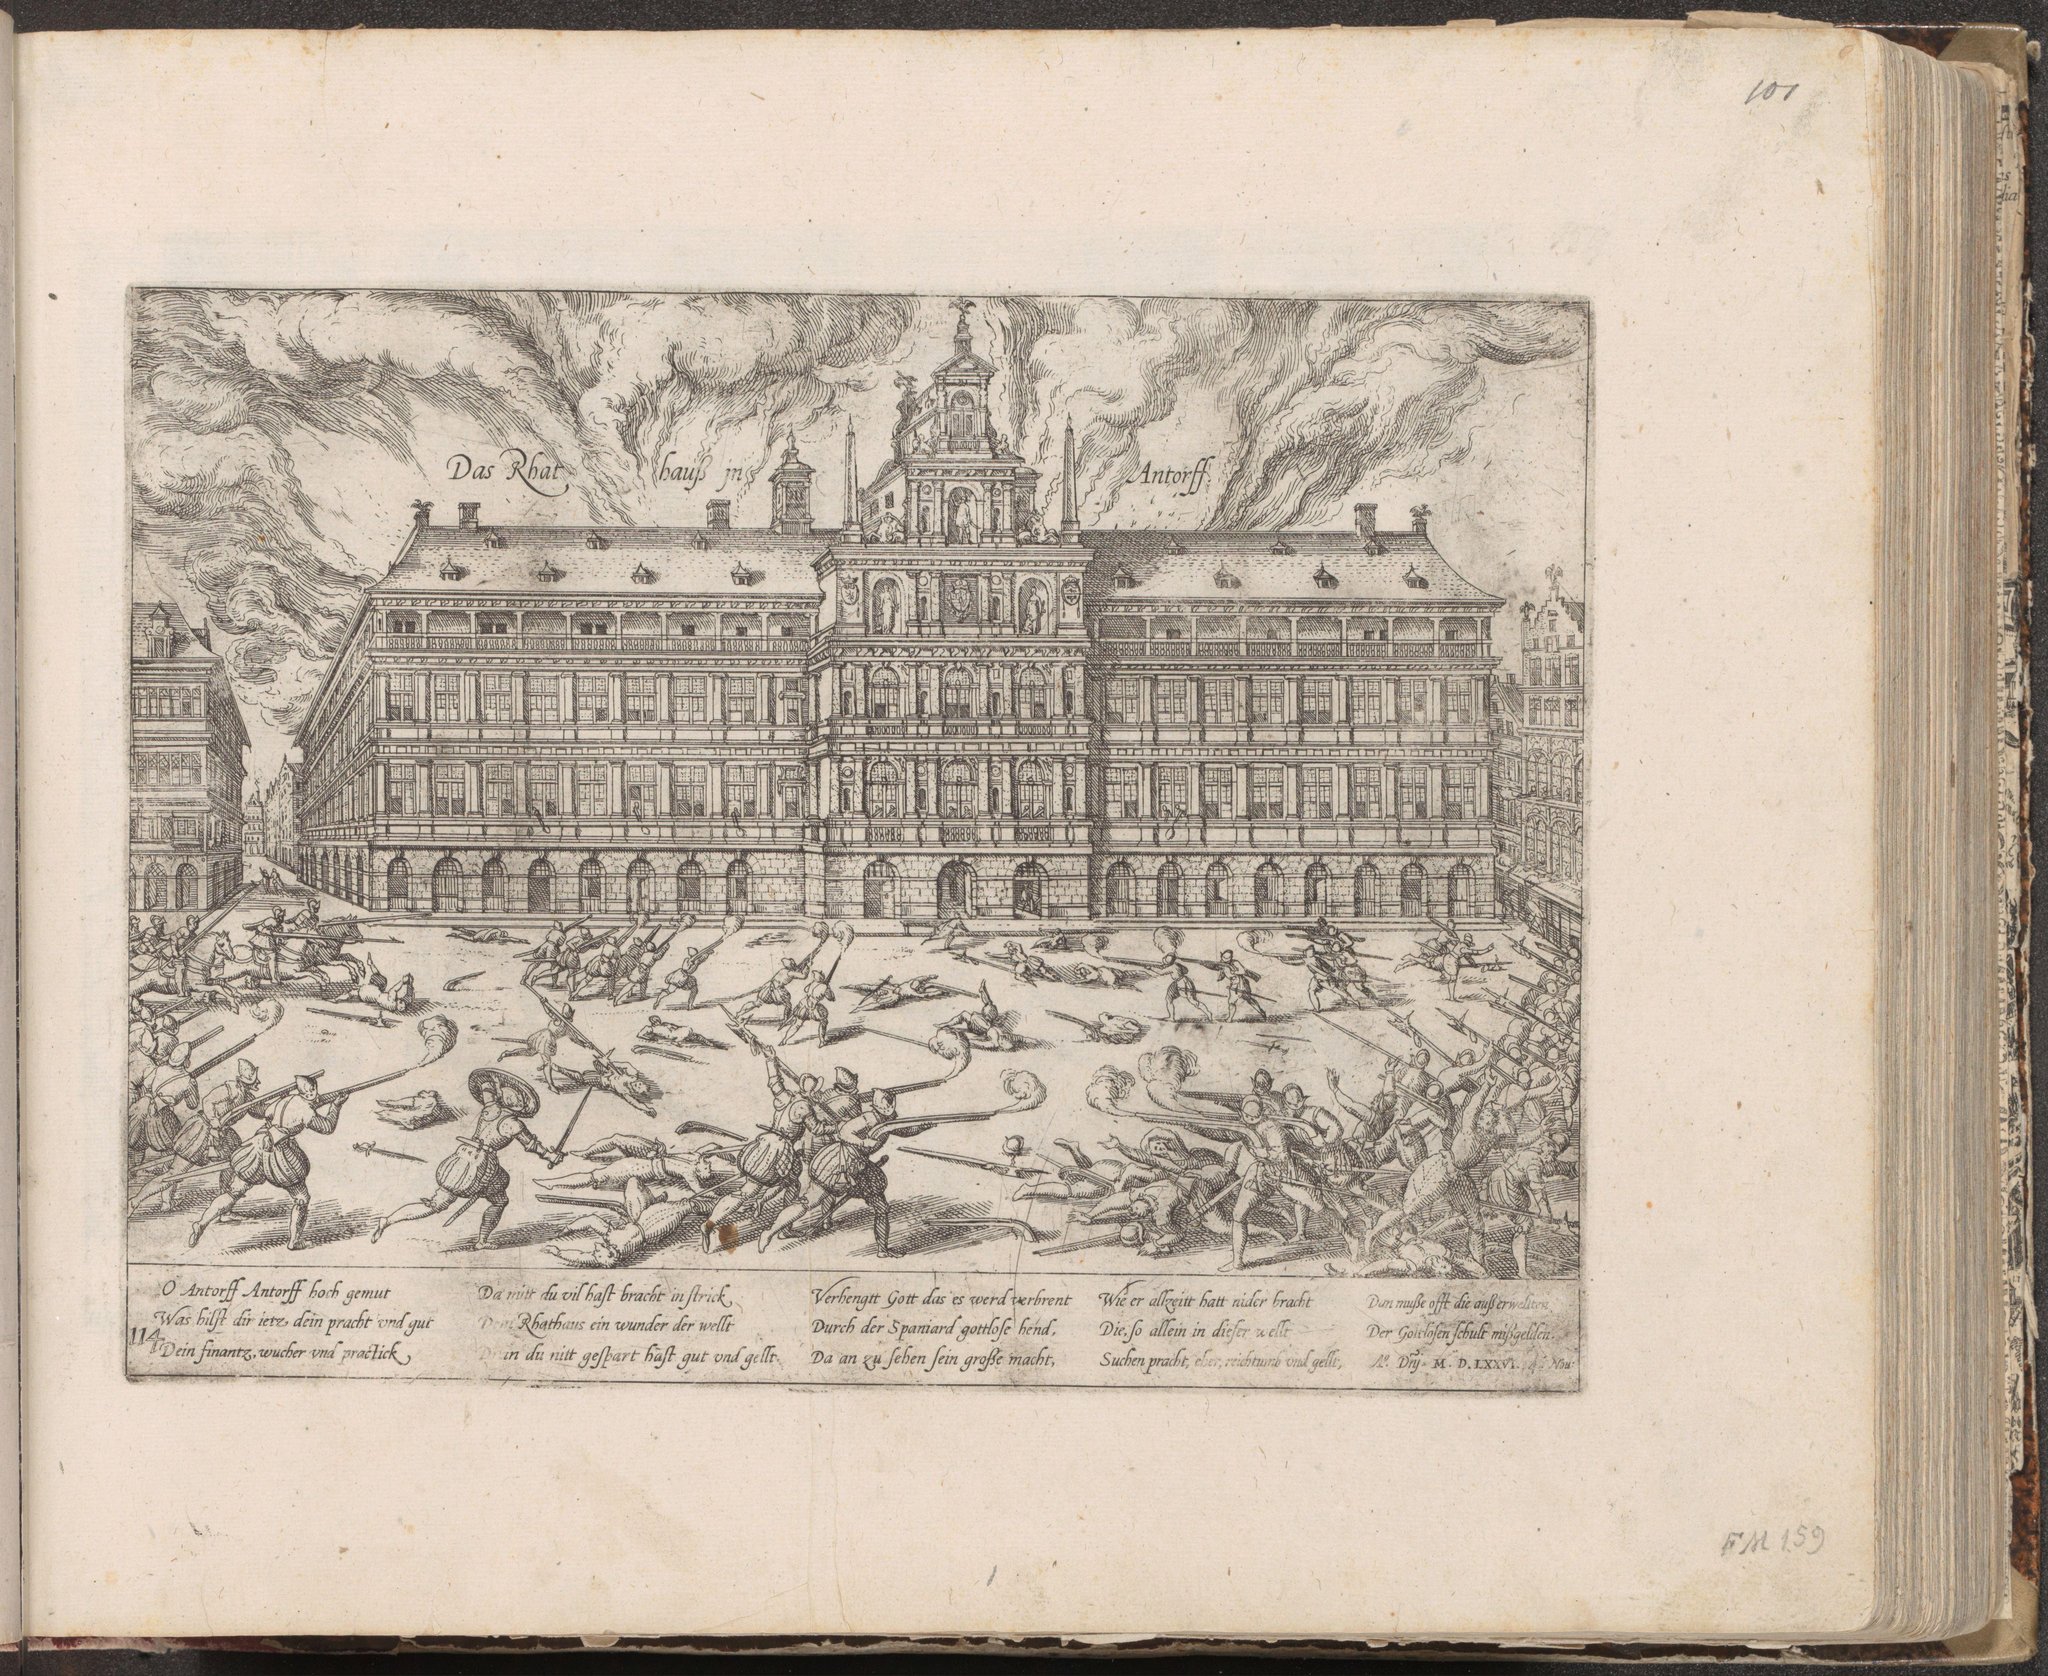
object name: history print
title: Spaanse Furie: stadhuis in brand, 1576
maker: frans hogenberg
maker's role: print maker, publisher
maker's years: 1538-1590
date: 1576-1579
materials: paper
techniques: etching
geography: cologne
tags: on fire, ablaze, massacre ~ war, antwerp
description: Spaanse Furie te Antwerpen, 4-7 november 1576. Het stadhuis van Antwerpen in brand. Op de Grote Markt voor het stadhuis gevechten tussen soldaten. Met onderschrift van 14 regels in het Duits. Genummerd: 114. De prent maakt deel uit van een album.